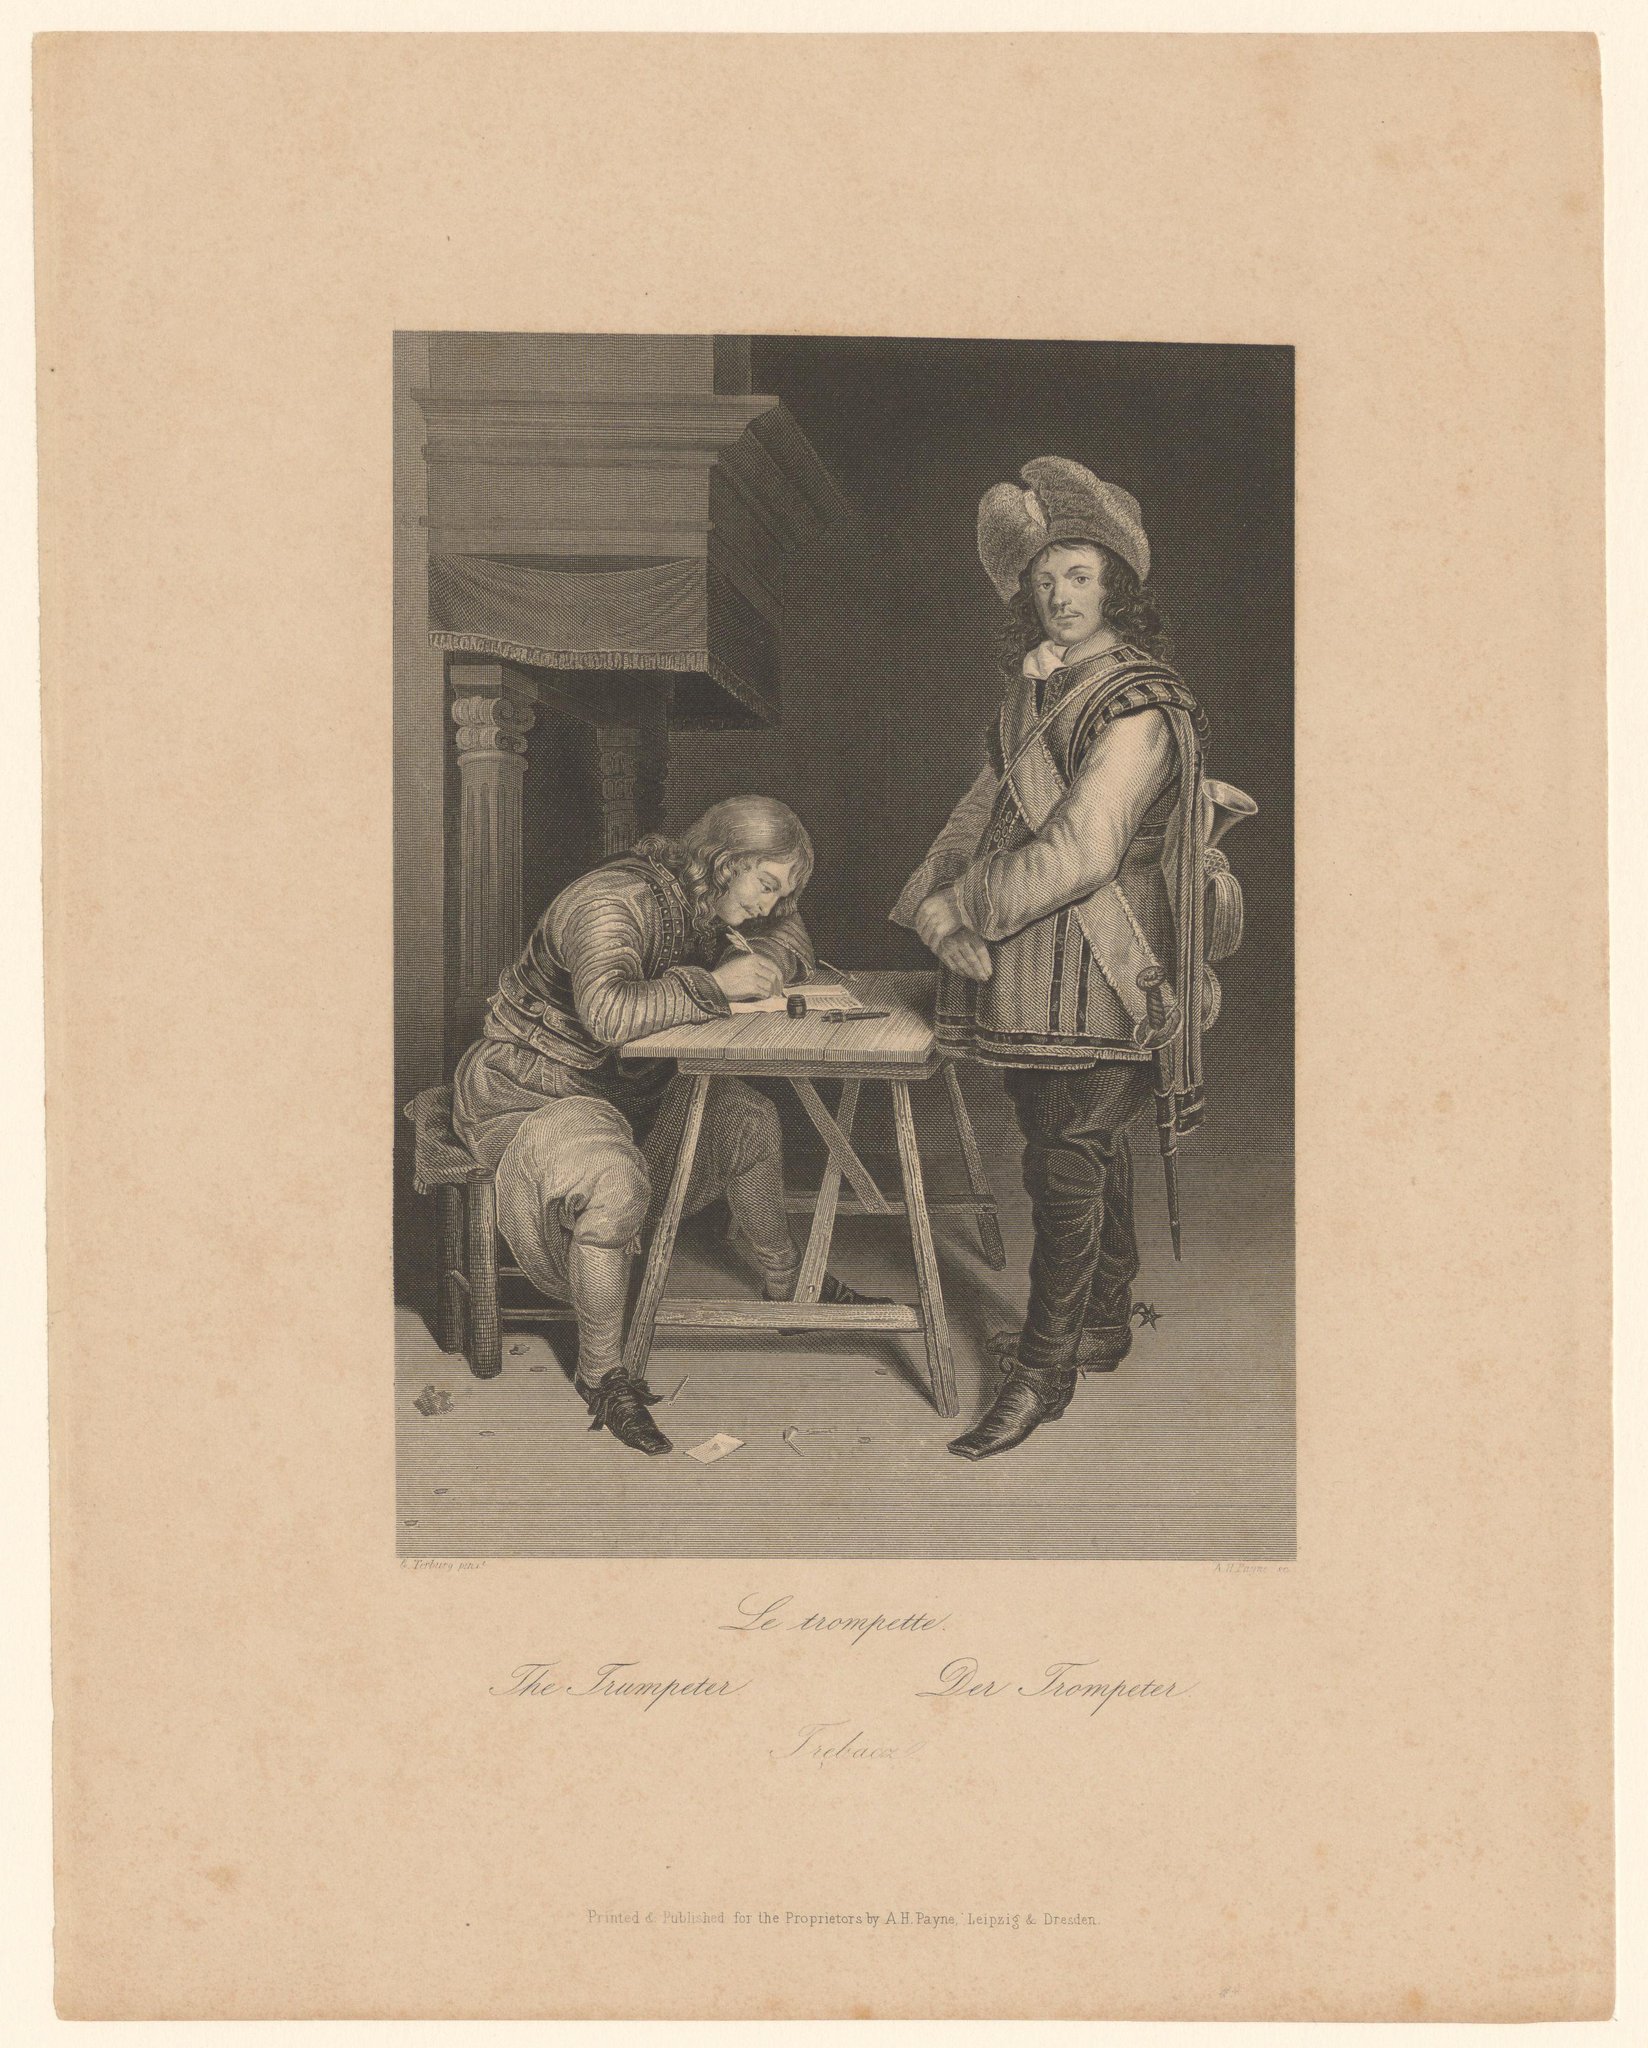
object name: print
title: Le trompette / the Trumpeter / Der Trompeter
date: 1845-1902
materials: paper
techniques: engraving, etching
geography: dresden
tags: handwriting, writing as activity, horn, trumpet, cornet, trombone, tuba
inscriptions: collector's mark: Lugt 2228